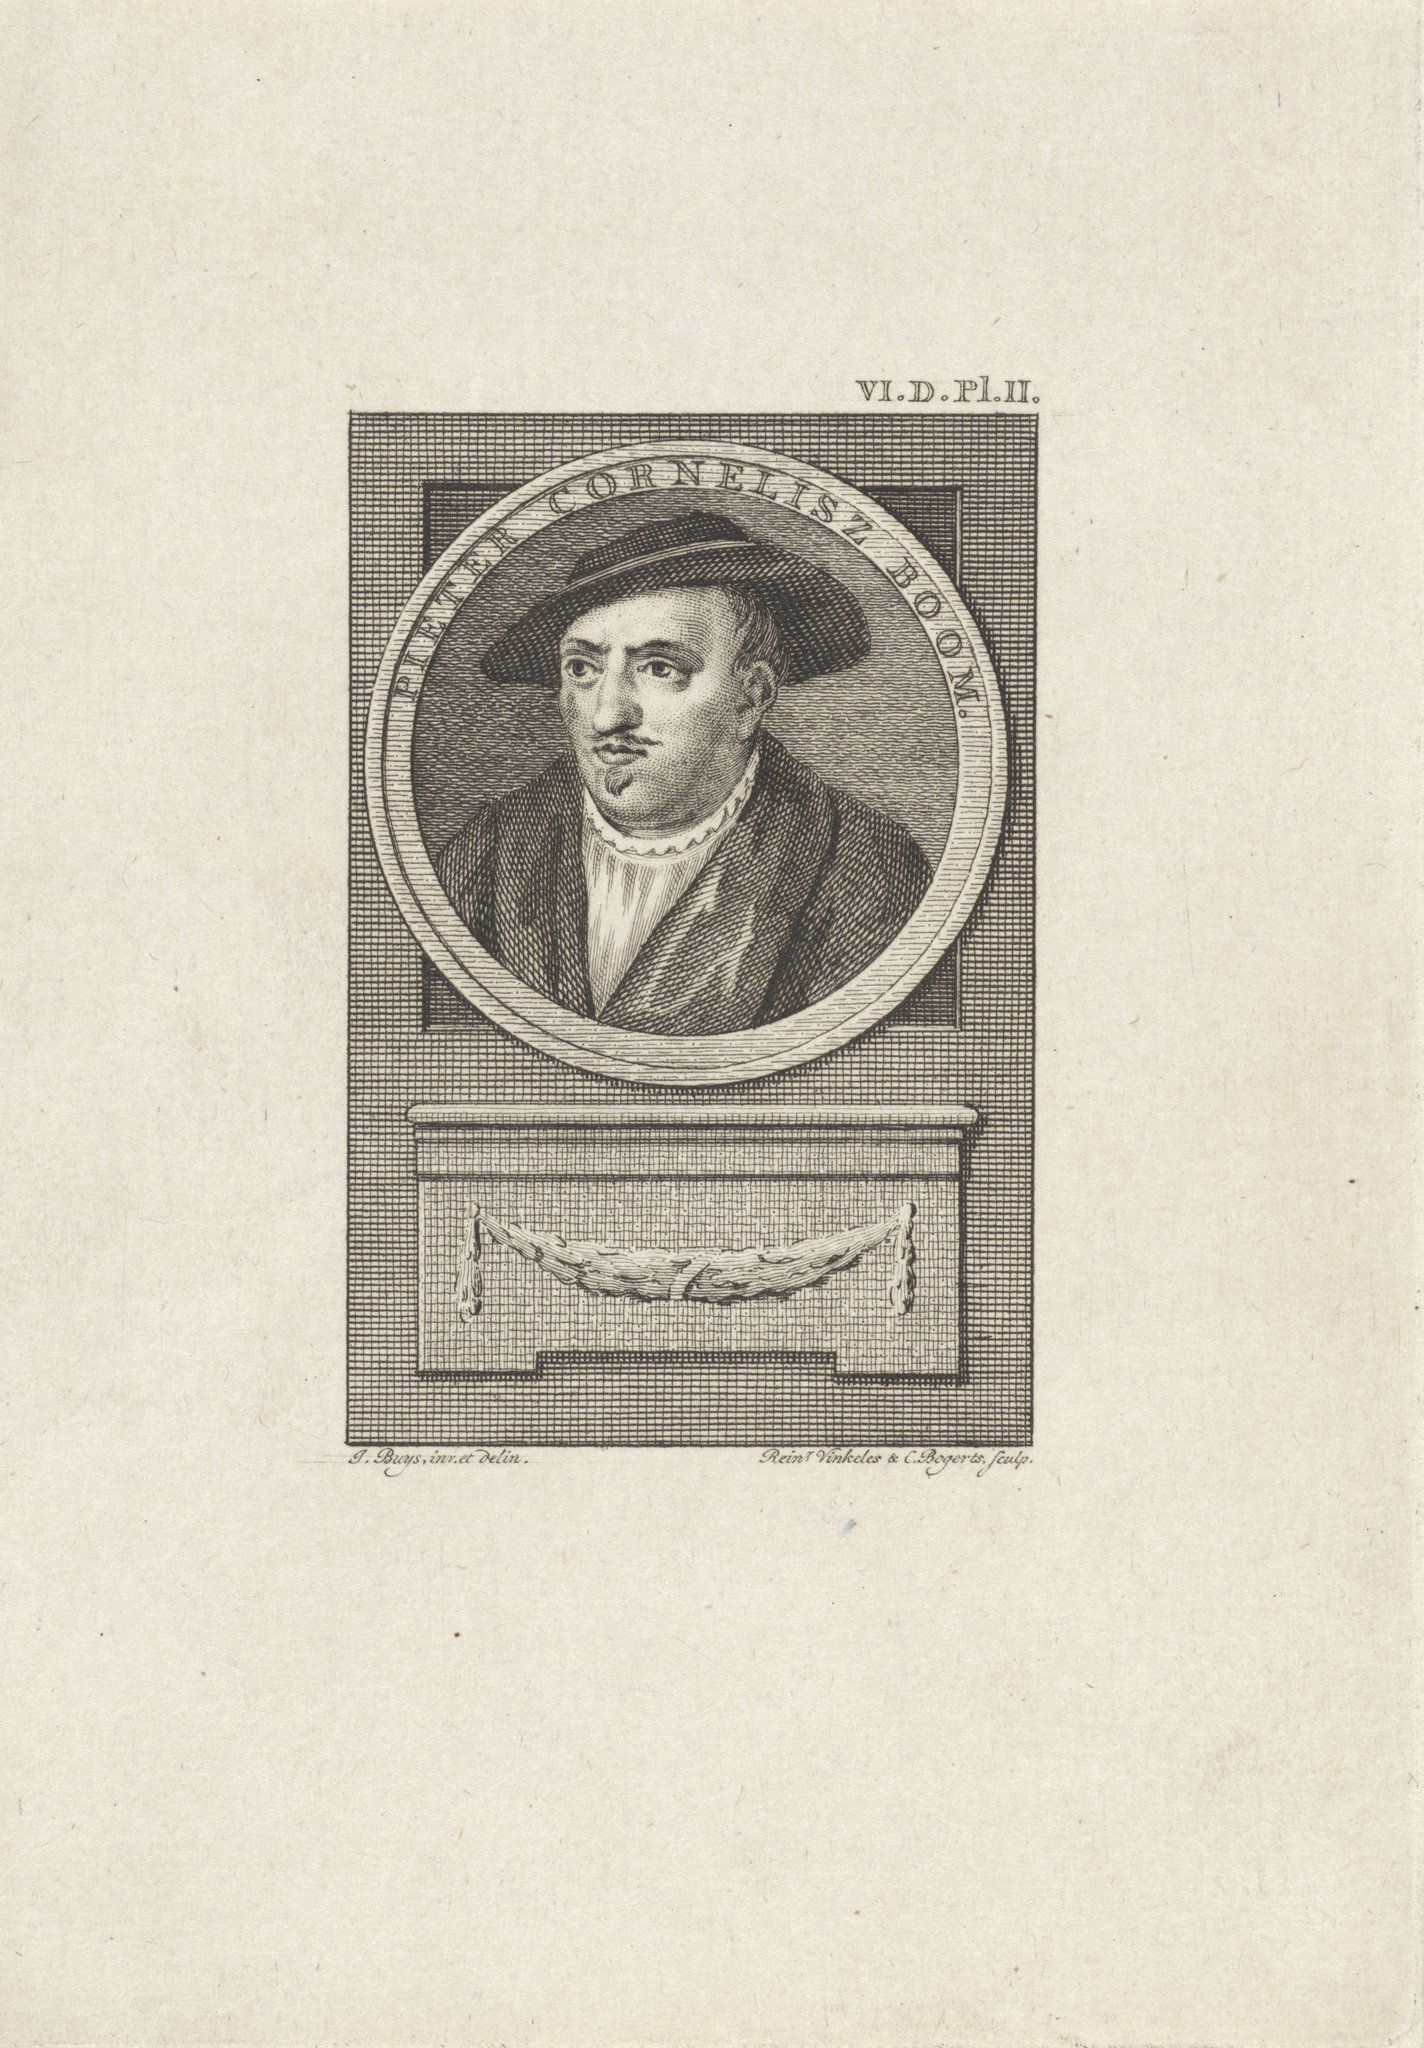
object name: print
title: Portret van Pieter Cornelisz Boom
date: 1783-1795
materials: paper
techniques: engraving, etching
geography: amsterdam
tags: mayor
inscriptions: collector's mark: Lugt 2228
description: Prent gebruikt in: Fokke, Jan. Geschiedenissen der Vereenigde Nederlanden voor de vaderlandsche jeugd Ie-XXVste deel. Amsterdam: Johannes Allart, 1783-1795. Deel VI.